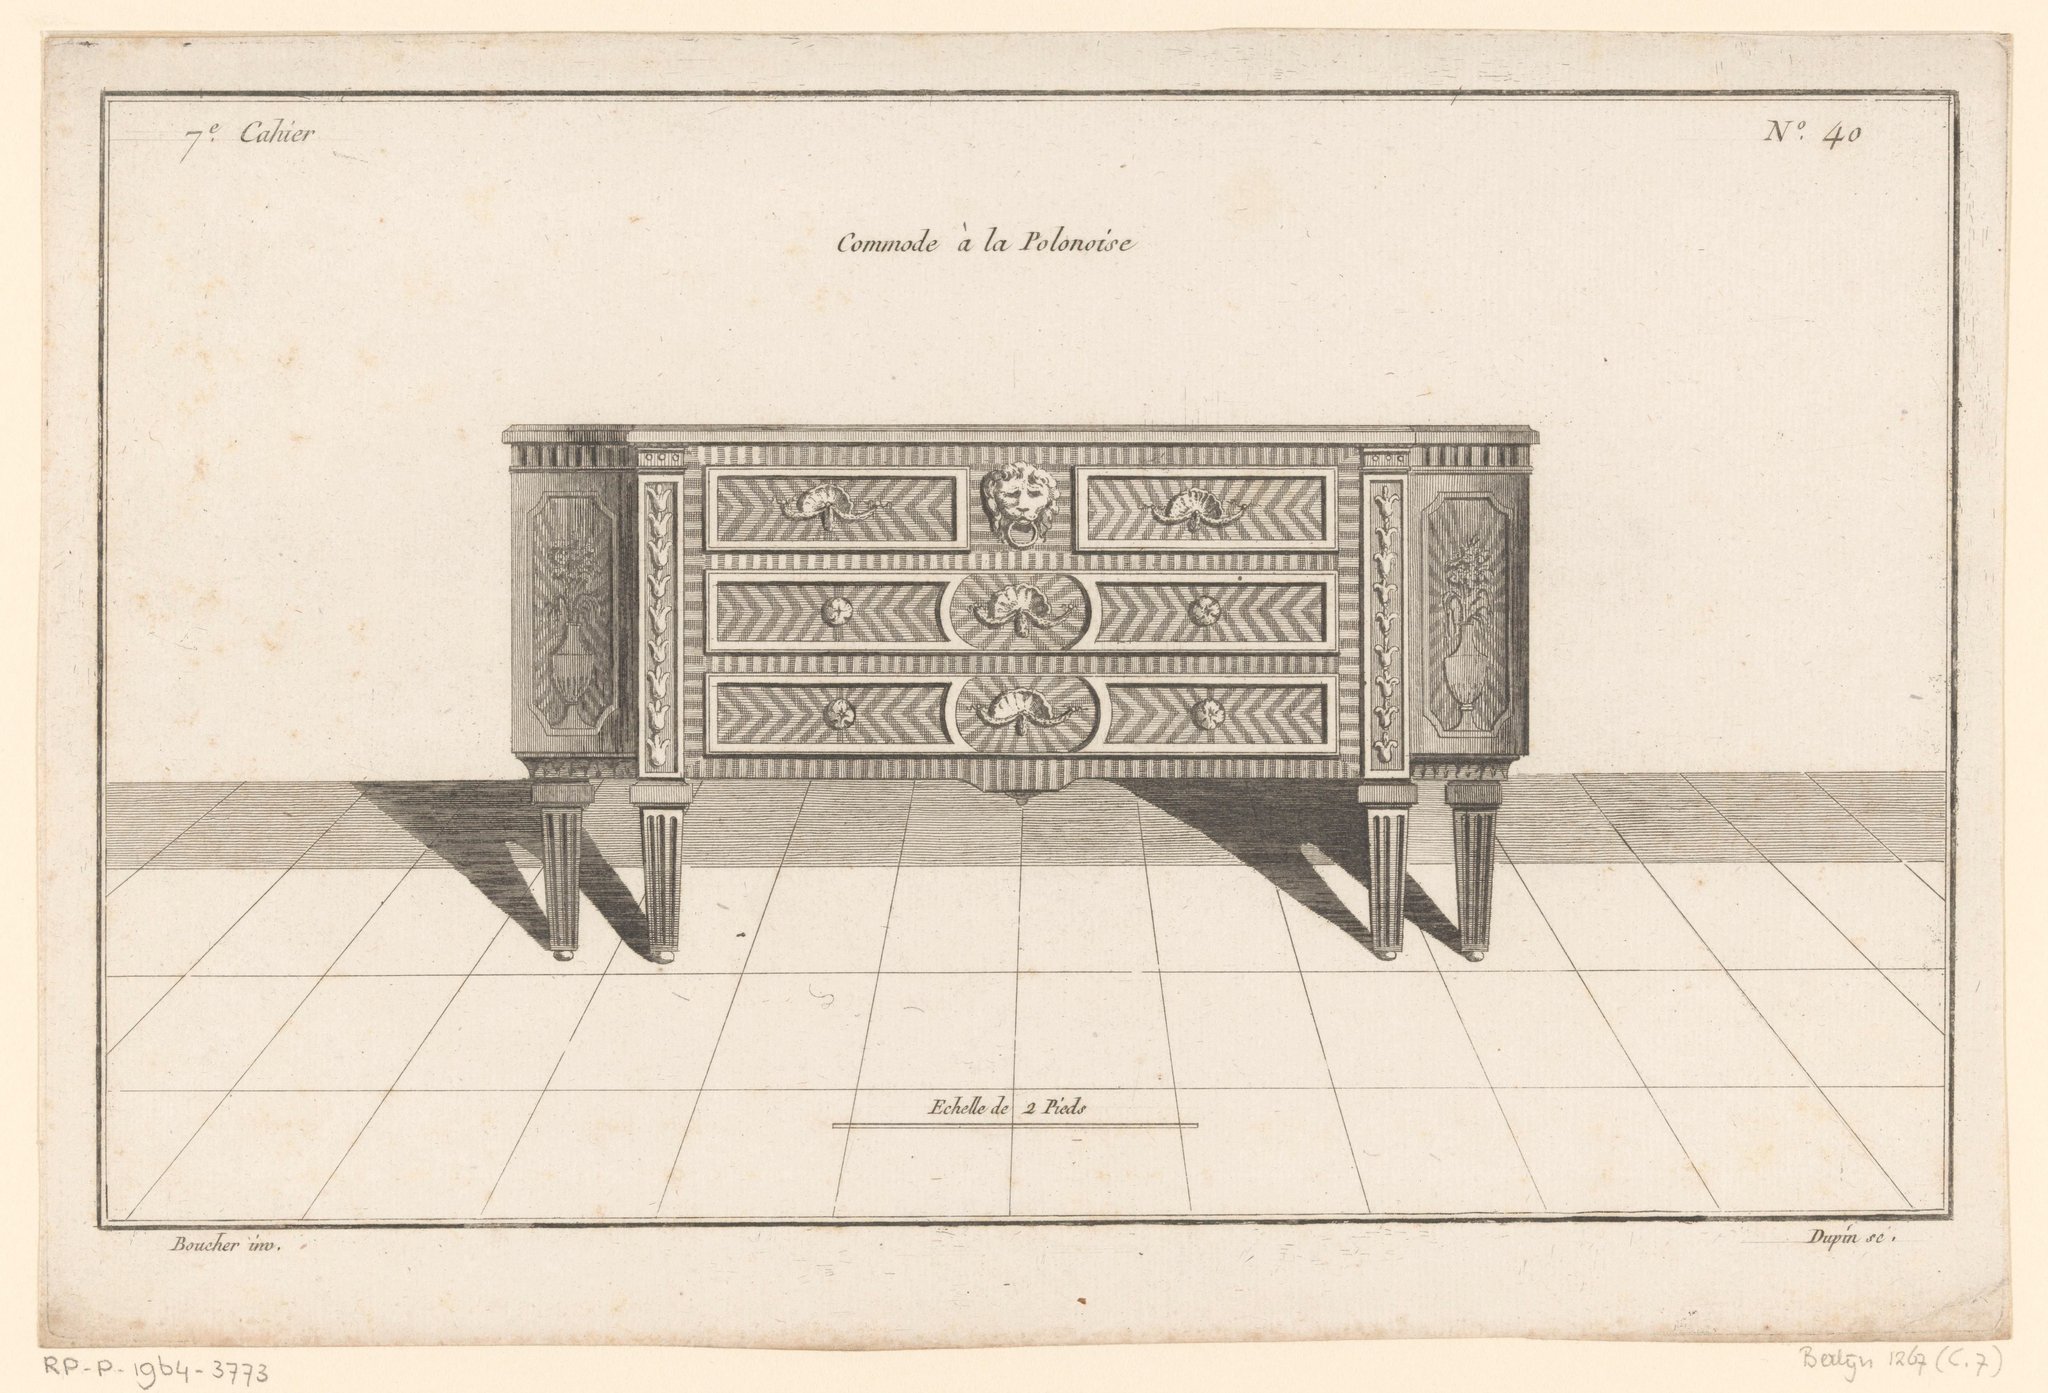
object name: ornament print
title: Commodes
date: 1772-1779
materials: paper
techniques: engraving, etching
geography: paris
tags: ornamental cupboard, lion's head ~ ornament, scallop, shell ~ ornament, flowers in a vase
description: Een geornamenteerde commode met vier lades, met leeuwenkop, schelpmotieven en bloemen in vazen. Prentnummer 40.